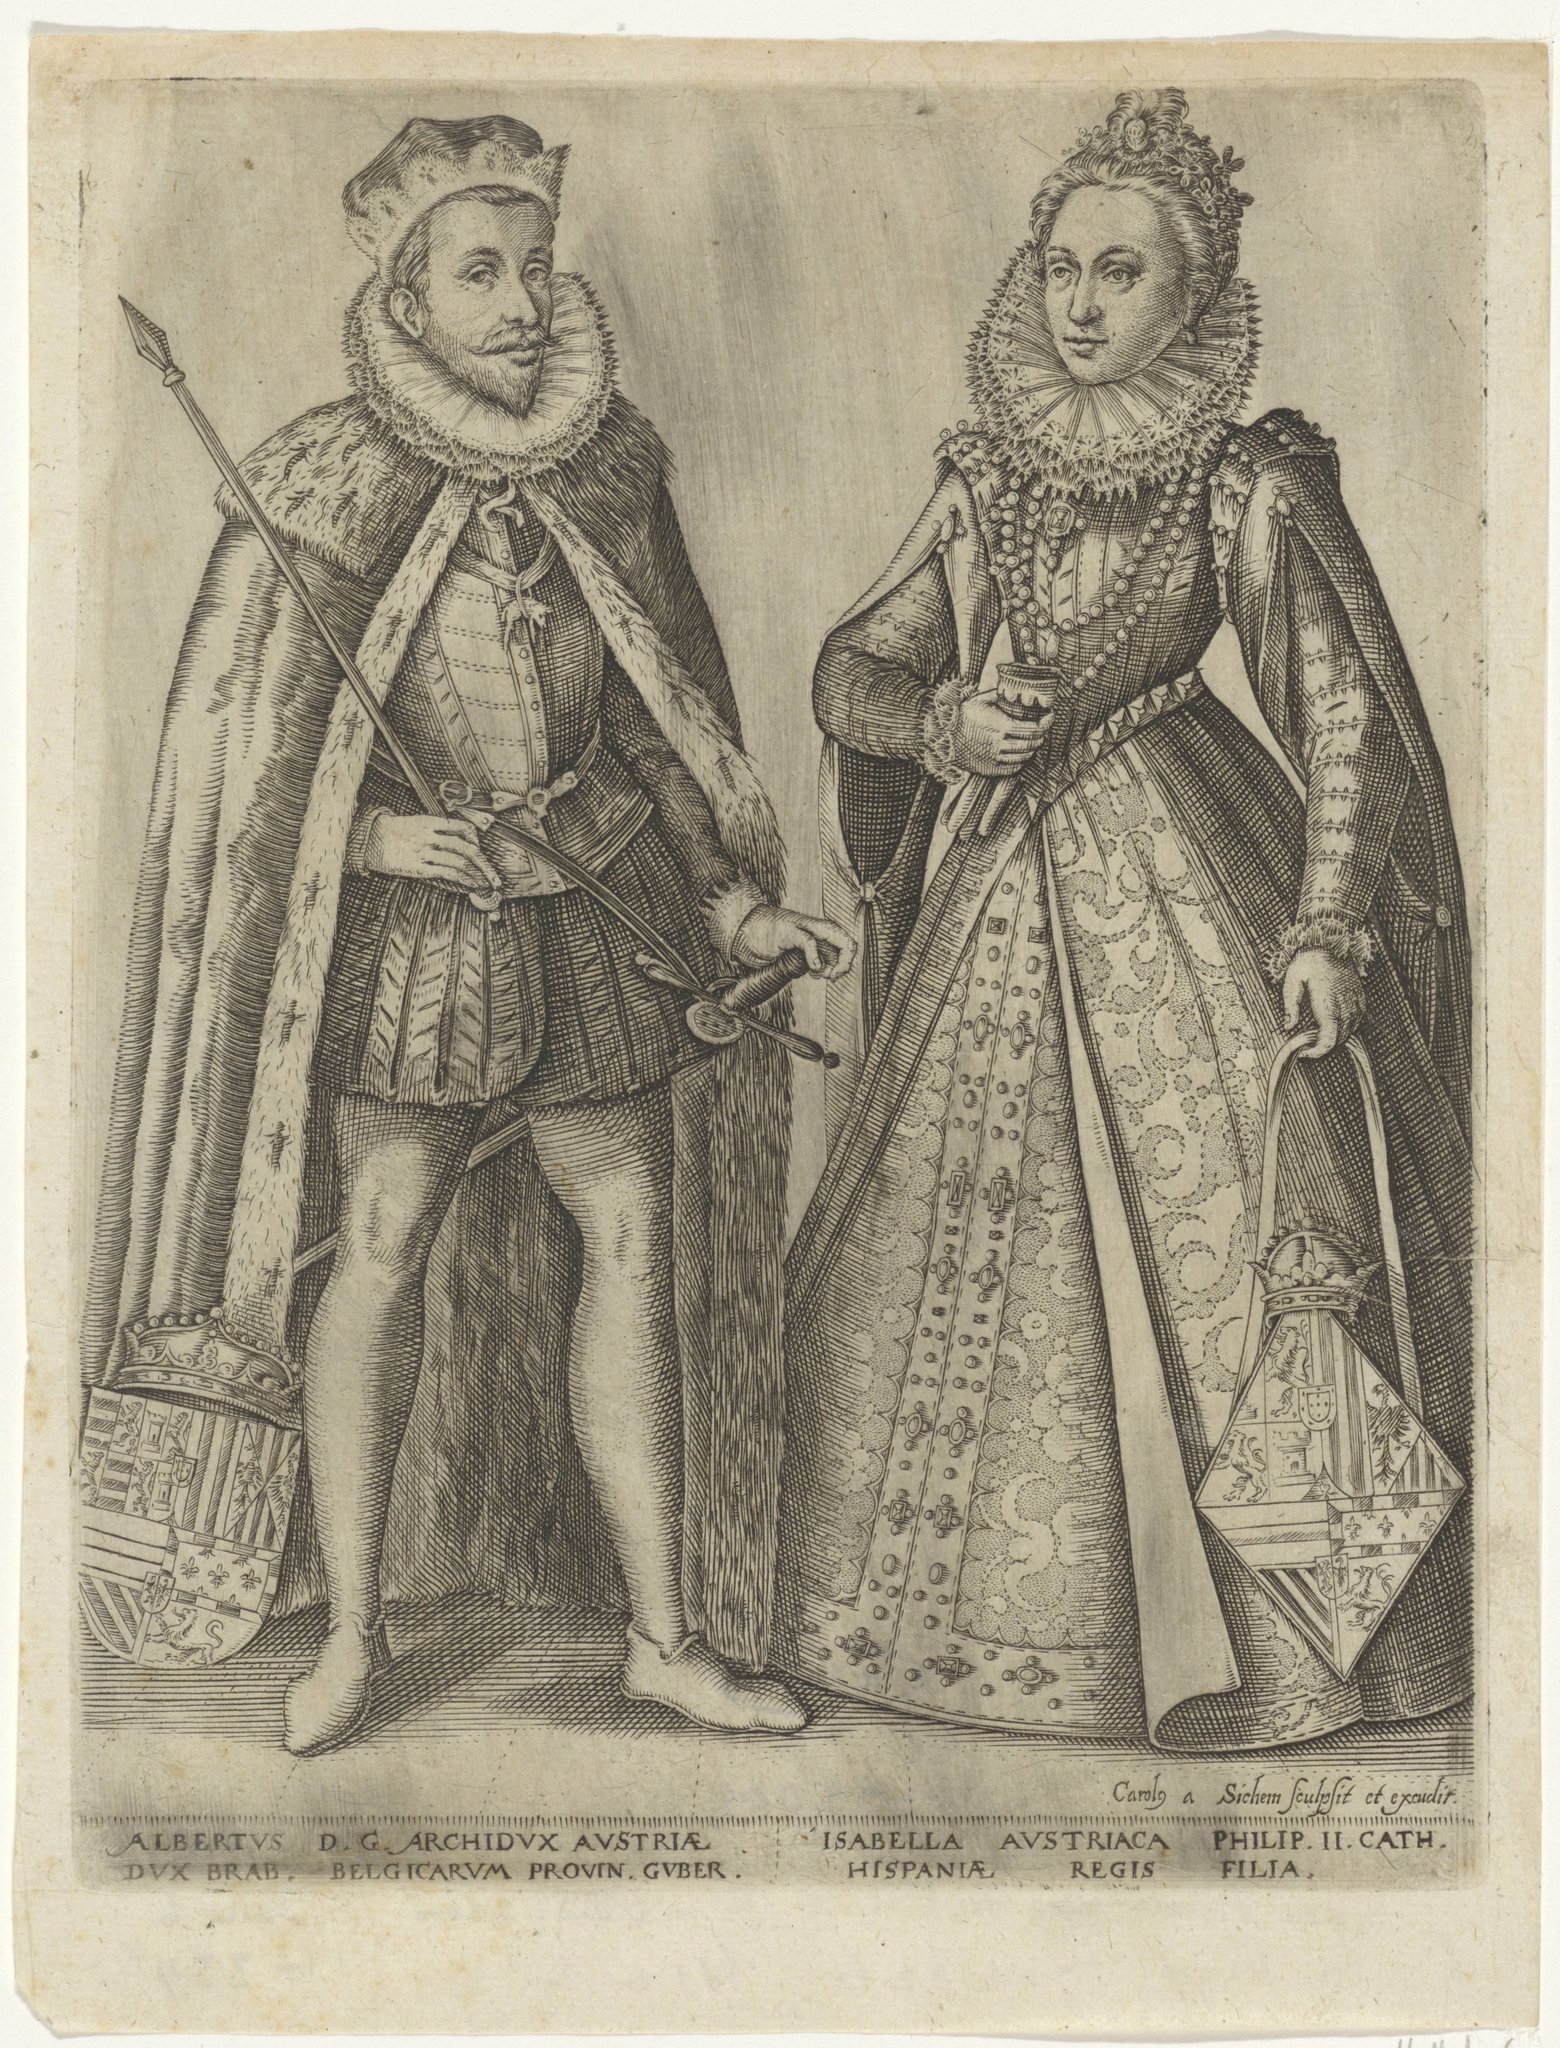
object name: print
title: Dubbelportret van Albrecht, aartshertog van Oostenrijk en Isabella van Spanje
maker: karel van sichem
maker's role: print maker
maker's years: 1575-1604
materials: paper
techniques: engraving, etching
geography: amsterdam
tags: infante van spanje isabella clara eugenia, brussels, albrecht aartshertog van oostenrijk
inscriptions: collector's mark: Lugt 2228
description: Dubbelportret van Albrecht, aartshertog van Oostenrijk en Isabella van Spanje, landvoogden van de Zuidelijke Nederlanden. Zijn wapenschild staat op de grond naast hem, zij draagt het hare aan een lint in haar hand. Onder de portretten hun beider naam en titels.